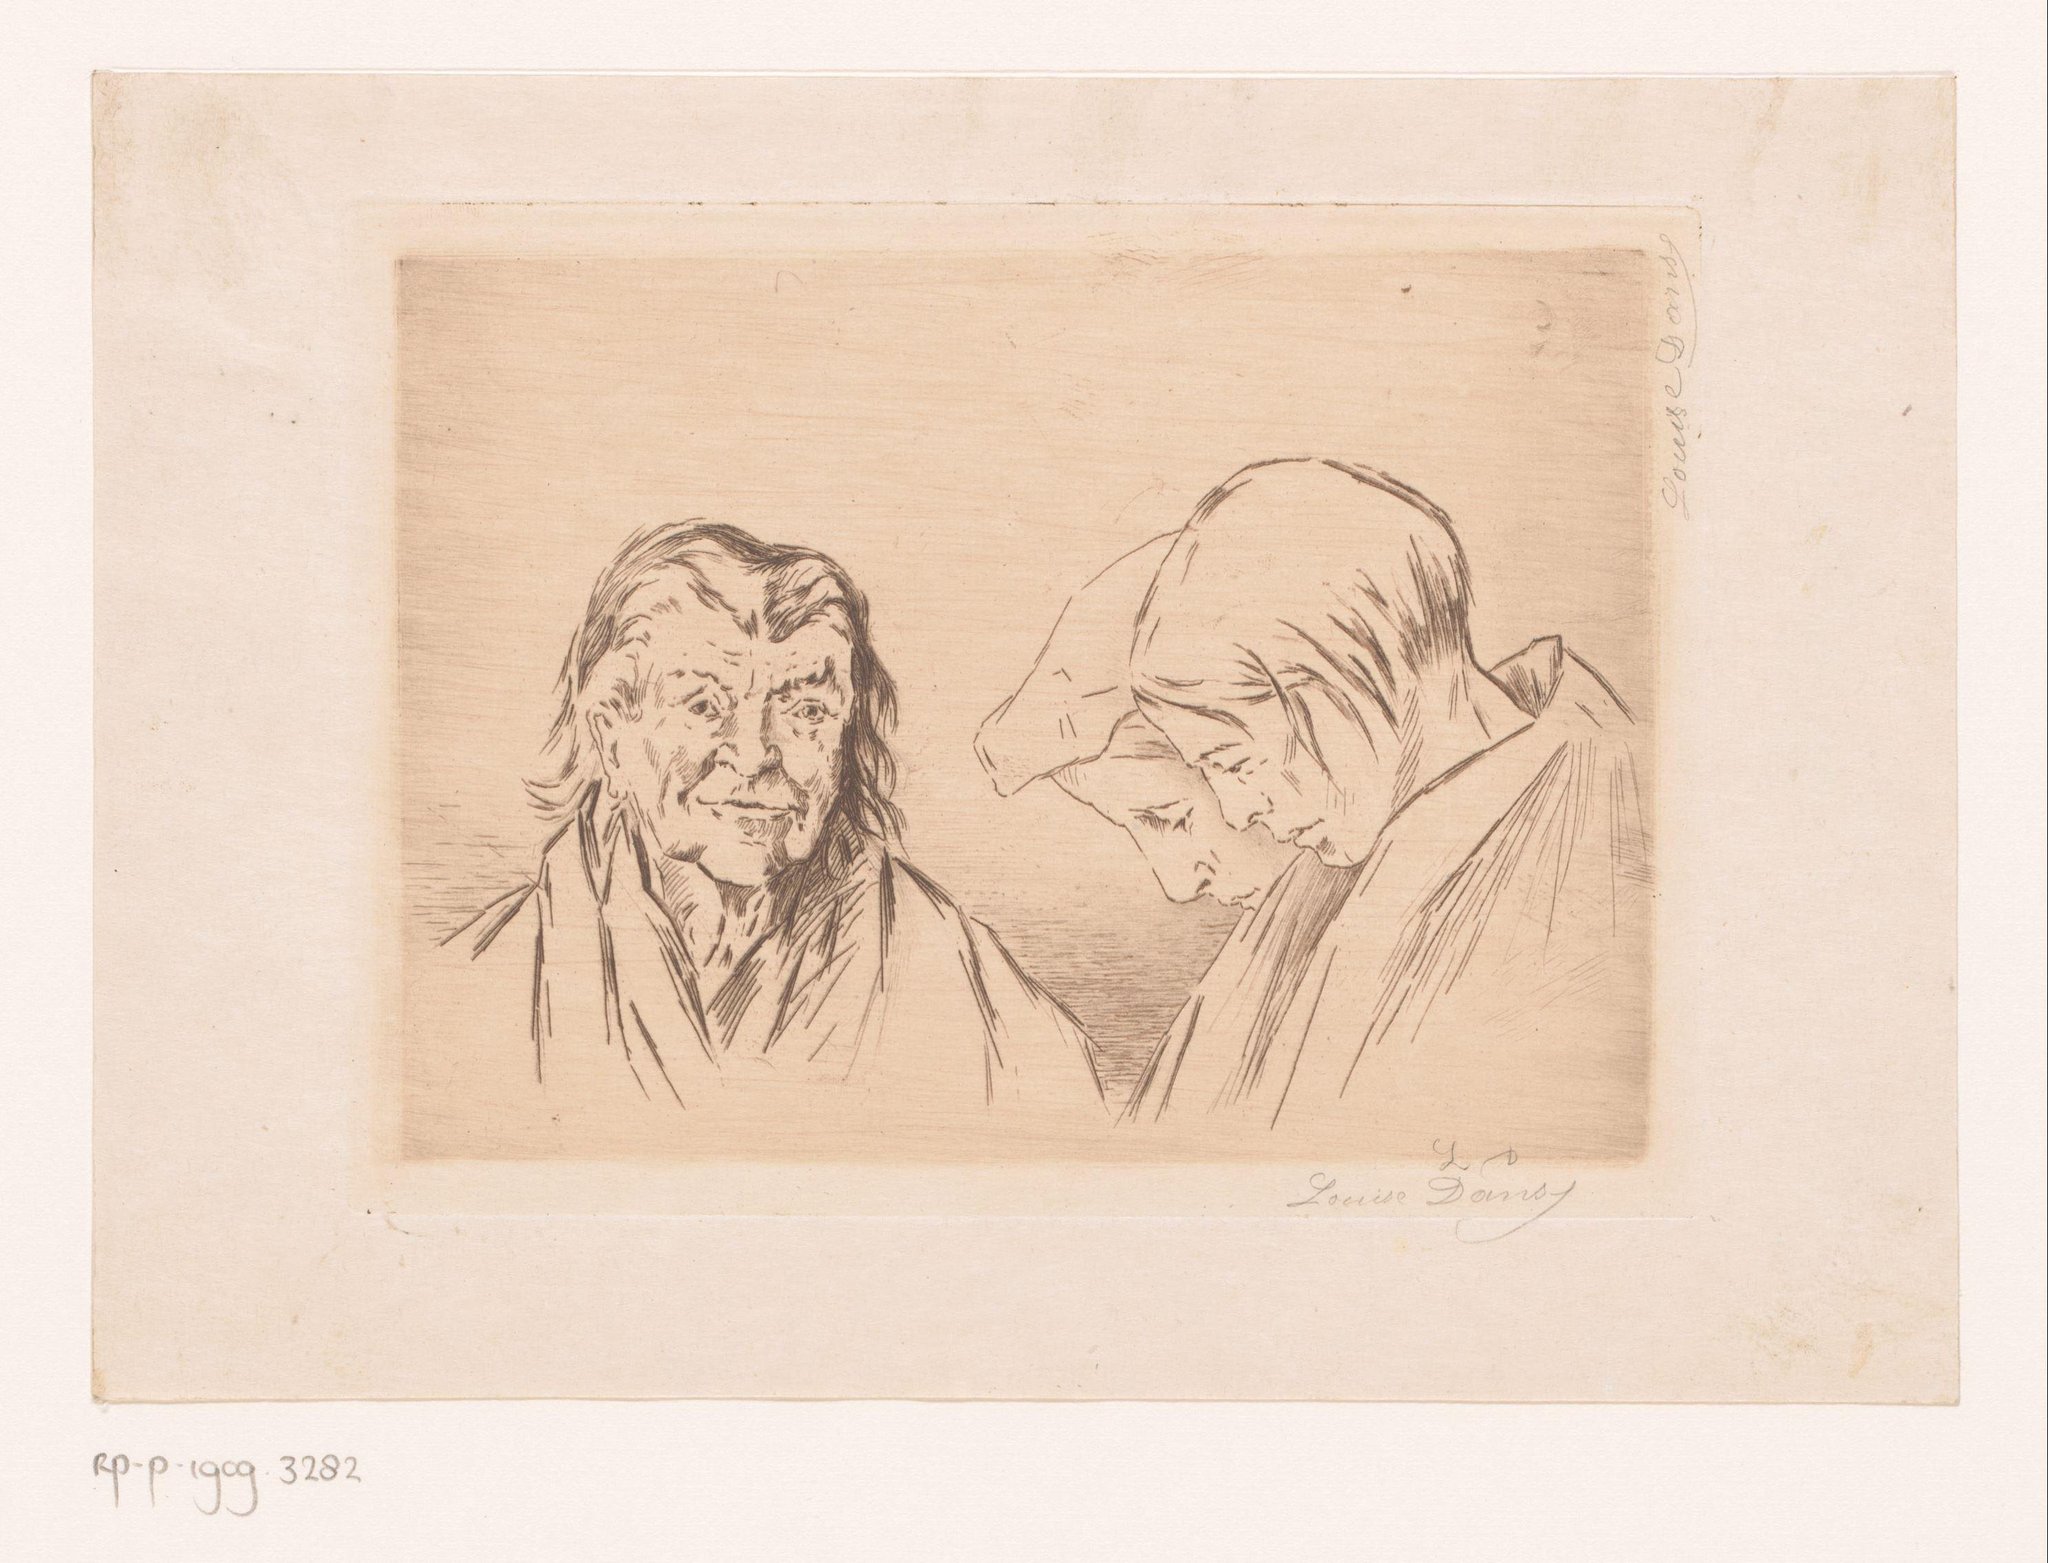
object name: print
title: Studie van drie vrouwen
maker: louise danse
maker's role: painter, print maker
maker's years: 1867-1948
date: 1877-1909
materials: paper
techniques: etching, intaglio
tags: adult woman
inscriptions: annotation: ‘Les Folles’, collector's mark: Lugt 2228